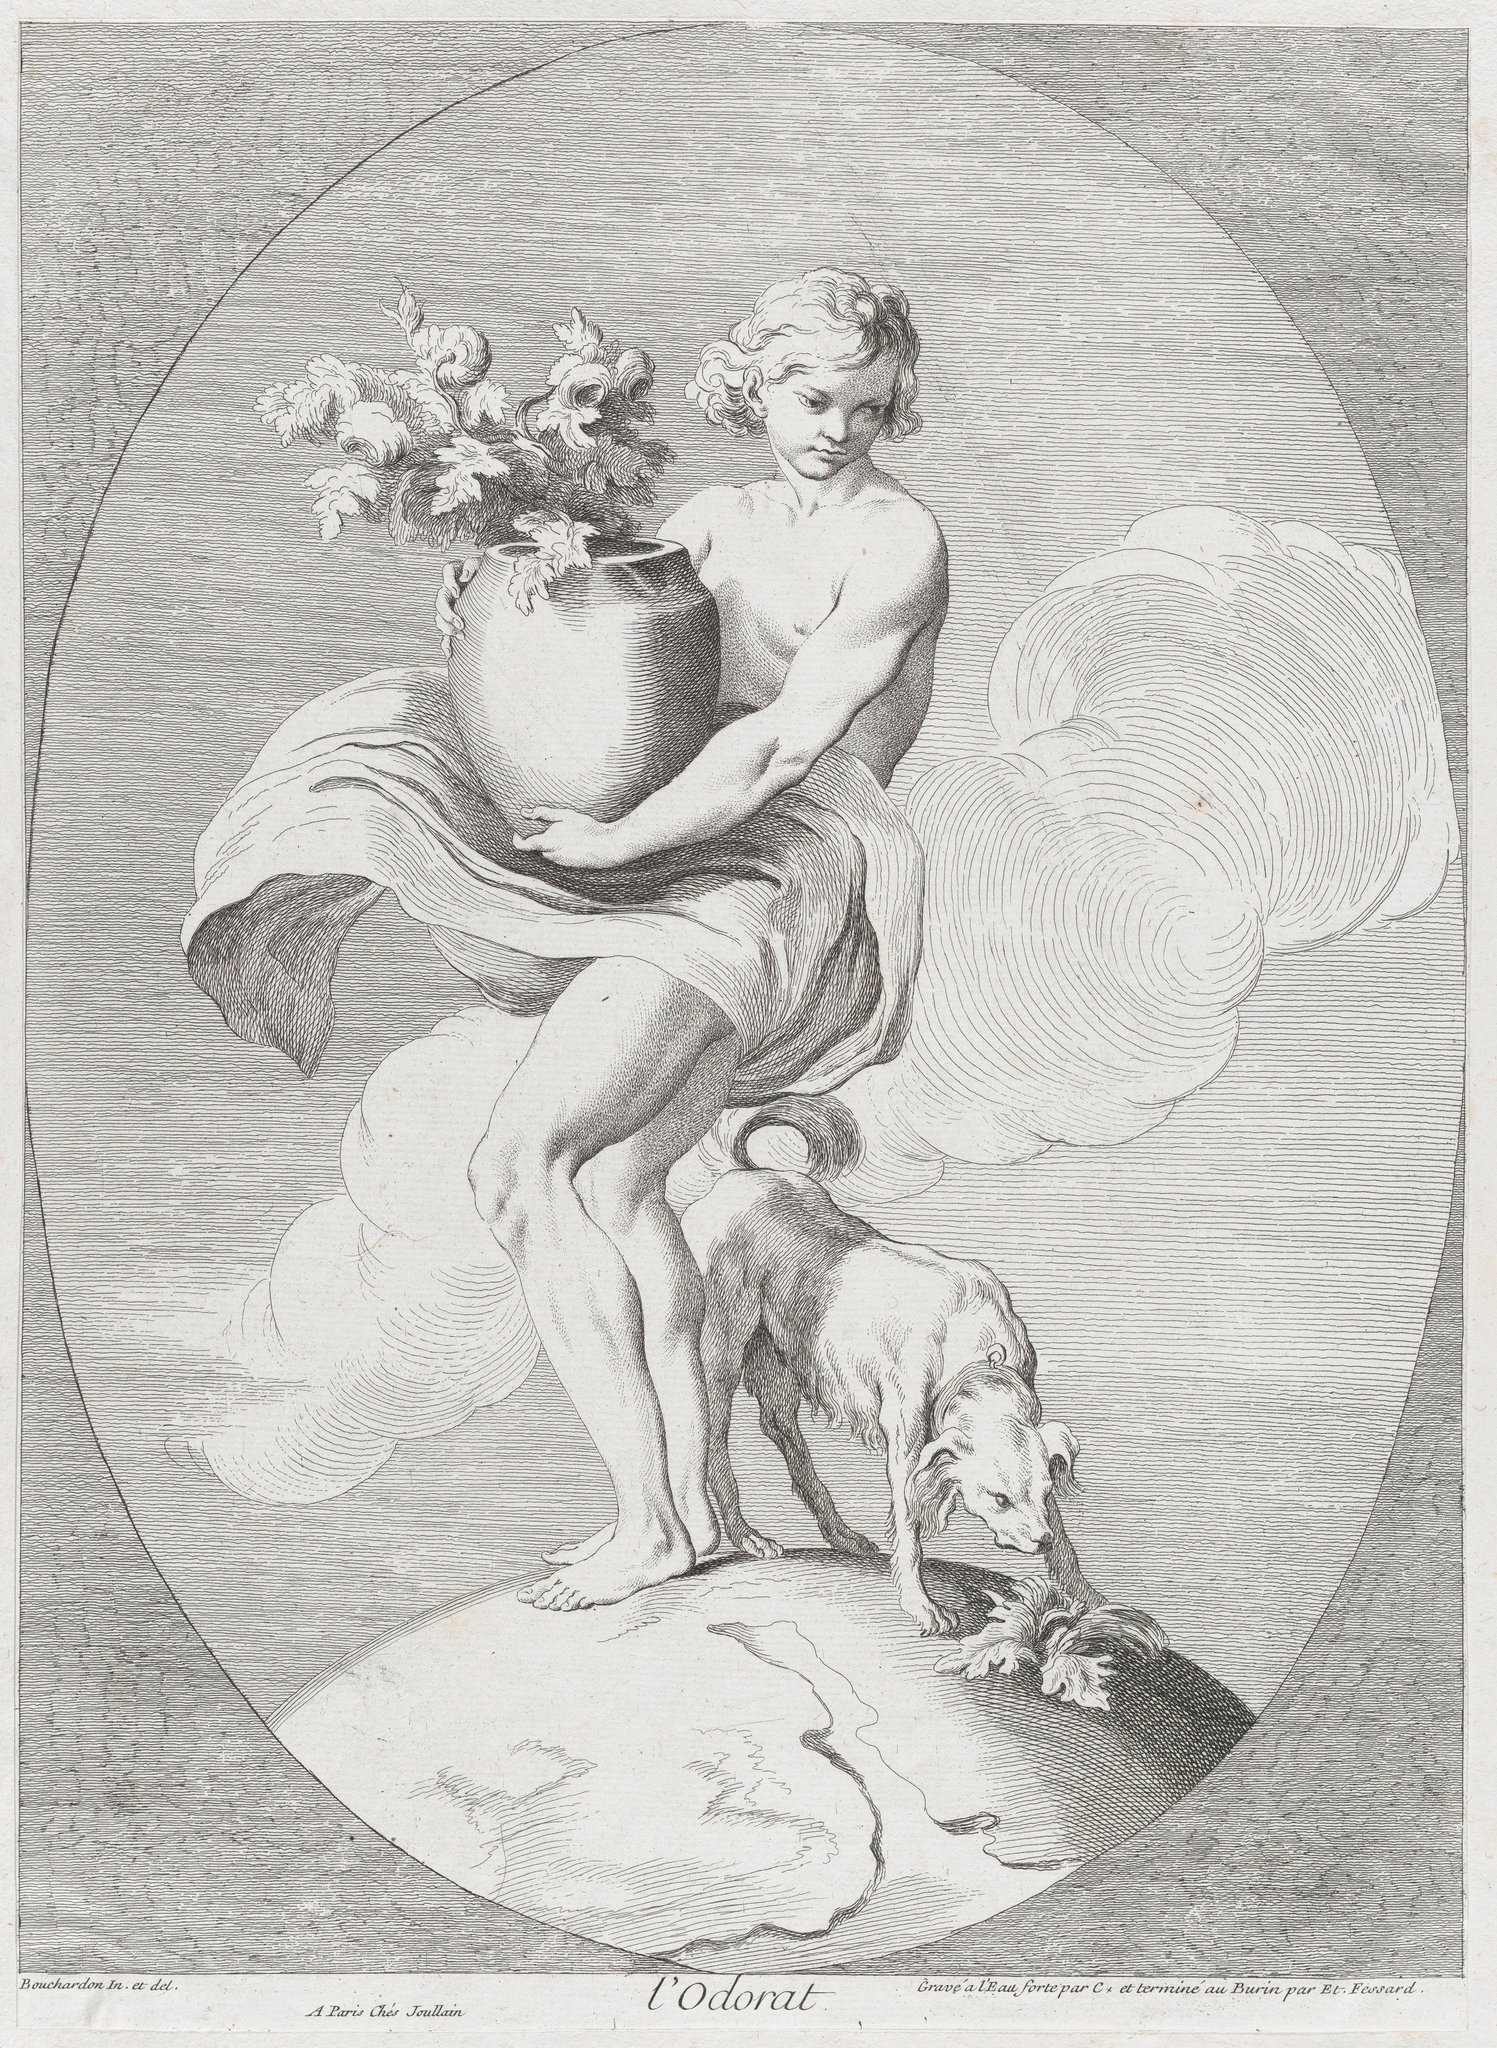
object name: print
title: Smell, from "The Five Senses"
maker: anne claude philippe de tubières, comte de caylus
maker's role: artist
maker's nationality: french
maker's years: 1692-1765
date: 1730-1765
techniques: engraving, etching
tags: female nudes,dogs,flowers